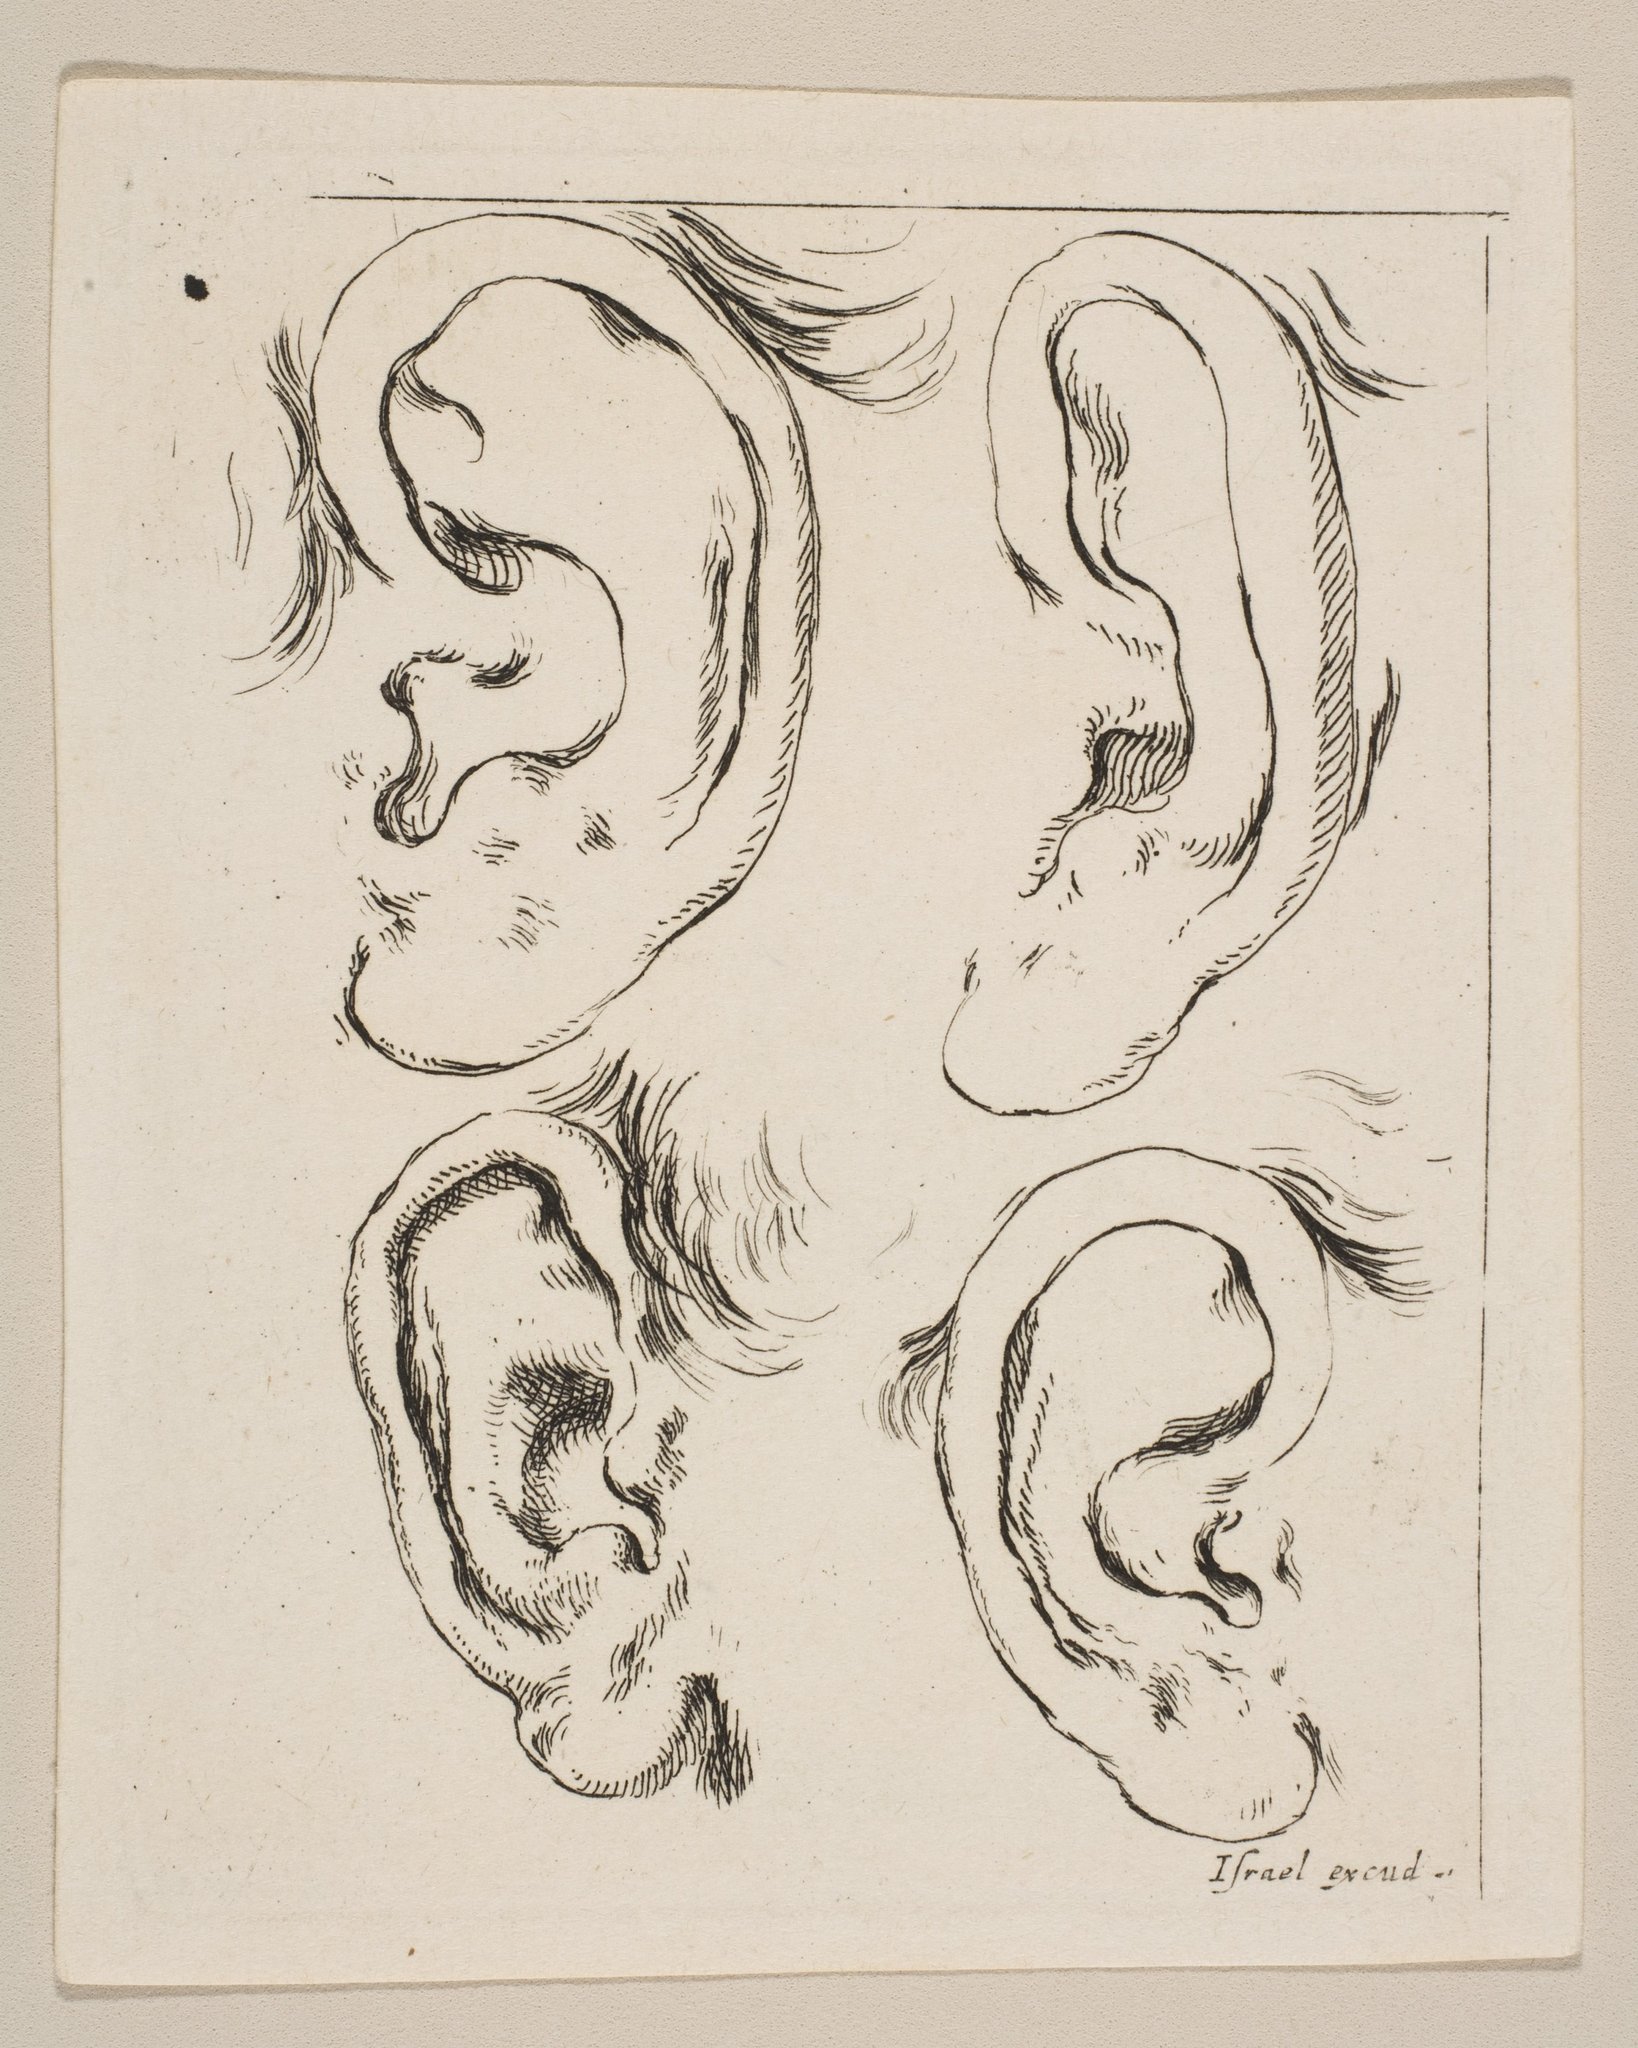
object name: print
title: Plate 5: four ears, from 'The Book for Learning to Draw' (Livre pour apprendre à dessiner)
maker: stefano della bella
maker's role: artist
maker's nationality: italian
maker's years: 1610-1664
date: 1649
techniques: etching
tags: ears